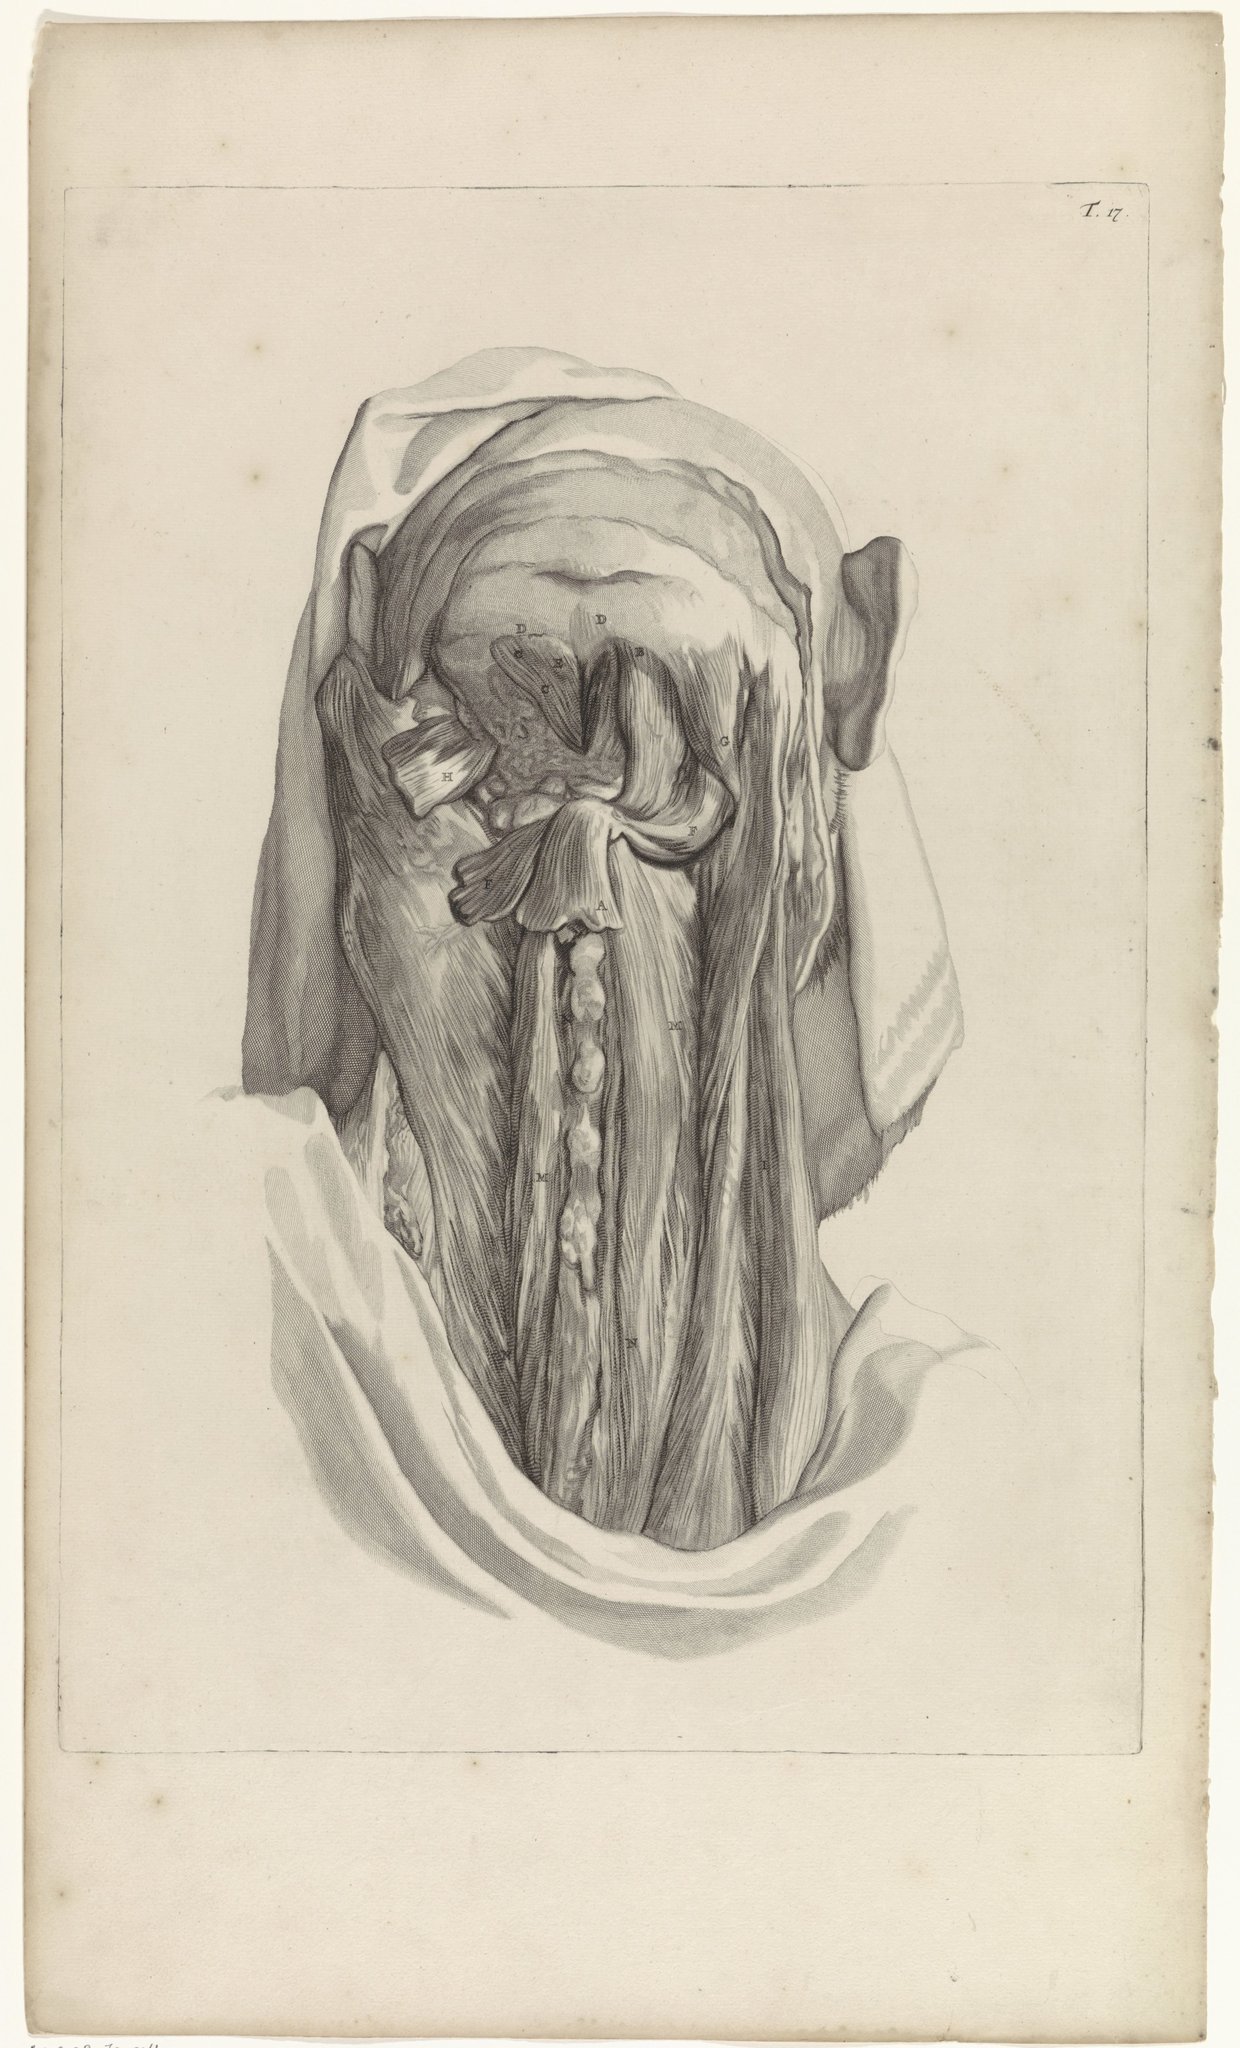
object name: print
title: Anatomische studie van de spieren van het achterhoofd en de nek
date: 1685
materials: paper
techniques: engraving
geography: amsterdam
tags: head (human) (+ back view), (human) skull, muscles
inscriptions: collector's mark: Lugt 2228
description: Boekillustratie voor Bidloo, Godefridus. Anatomia humani corporis centum & quinque tabulis, per art. G. de Lairesse ad vivum delineatis, de monstrata, veterum recentiorumque inventis explicata plurimisque, hactenus non detectis, illustrata. Amsterdam: Weduwe Joannes van Someren, Hendrick Boom en erven Dirk Boom, 1685.